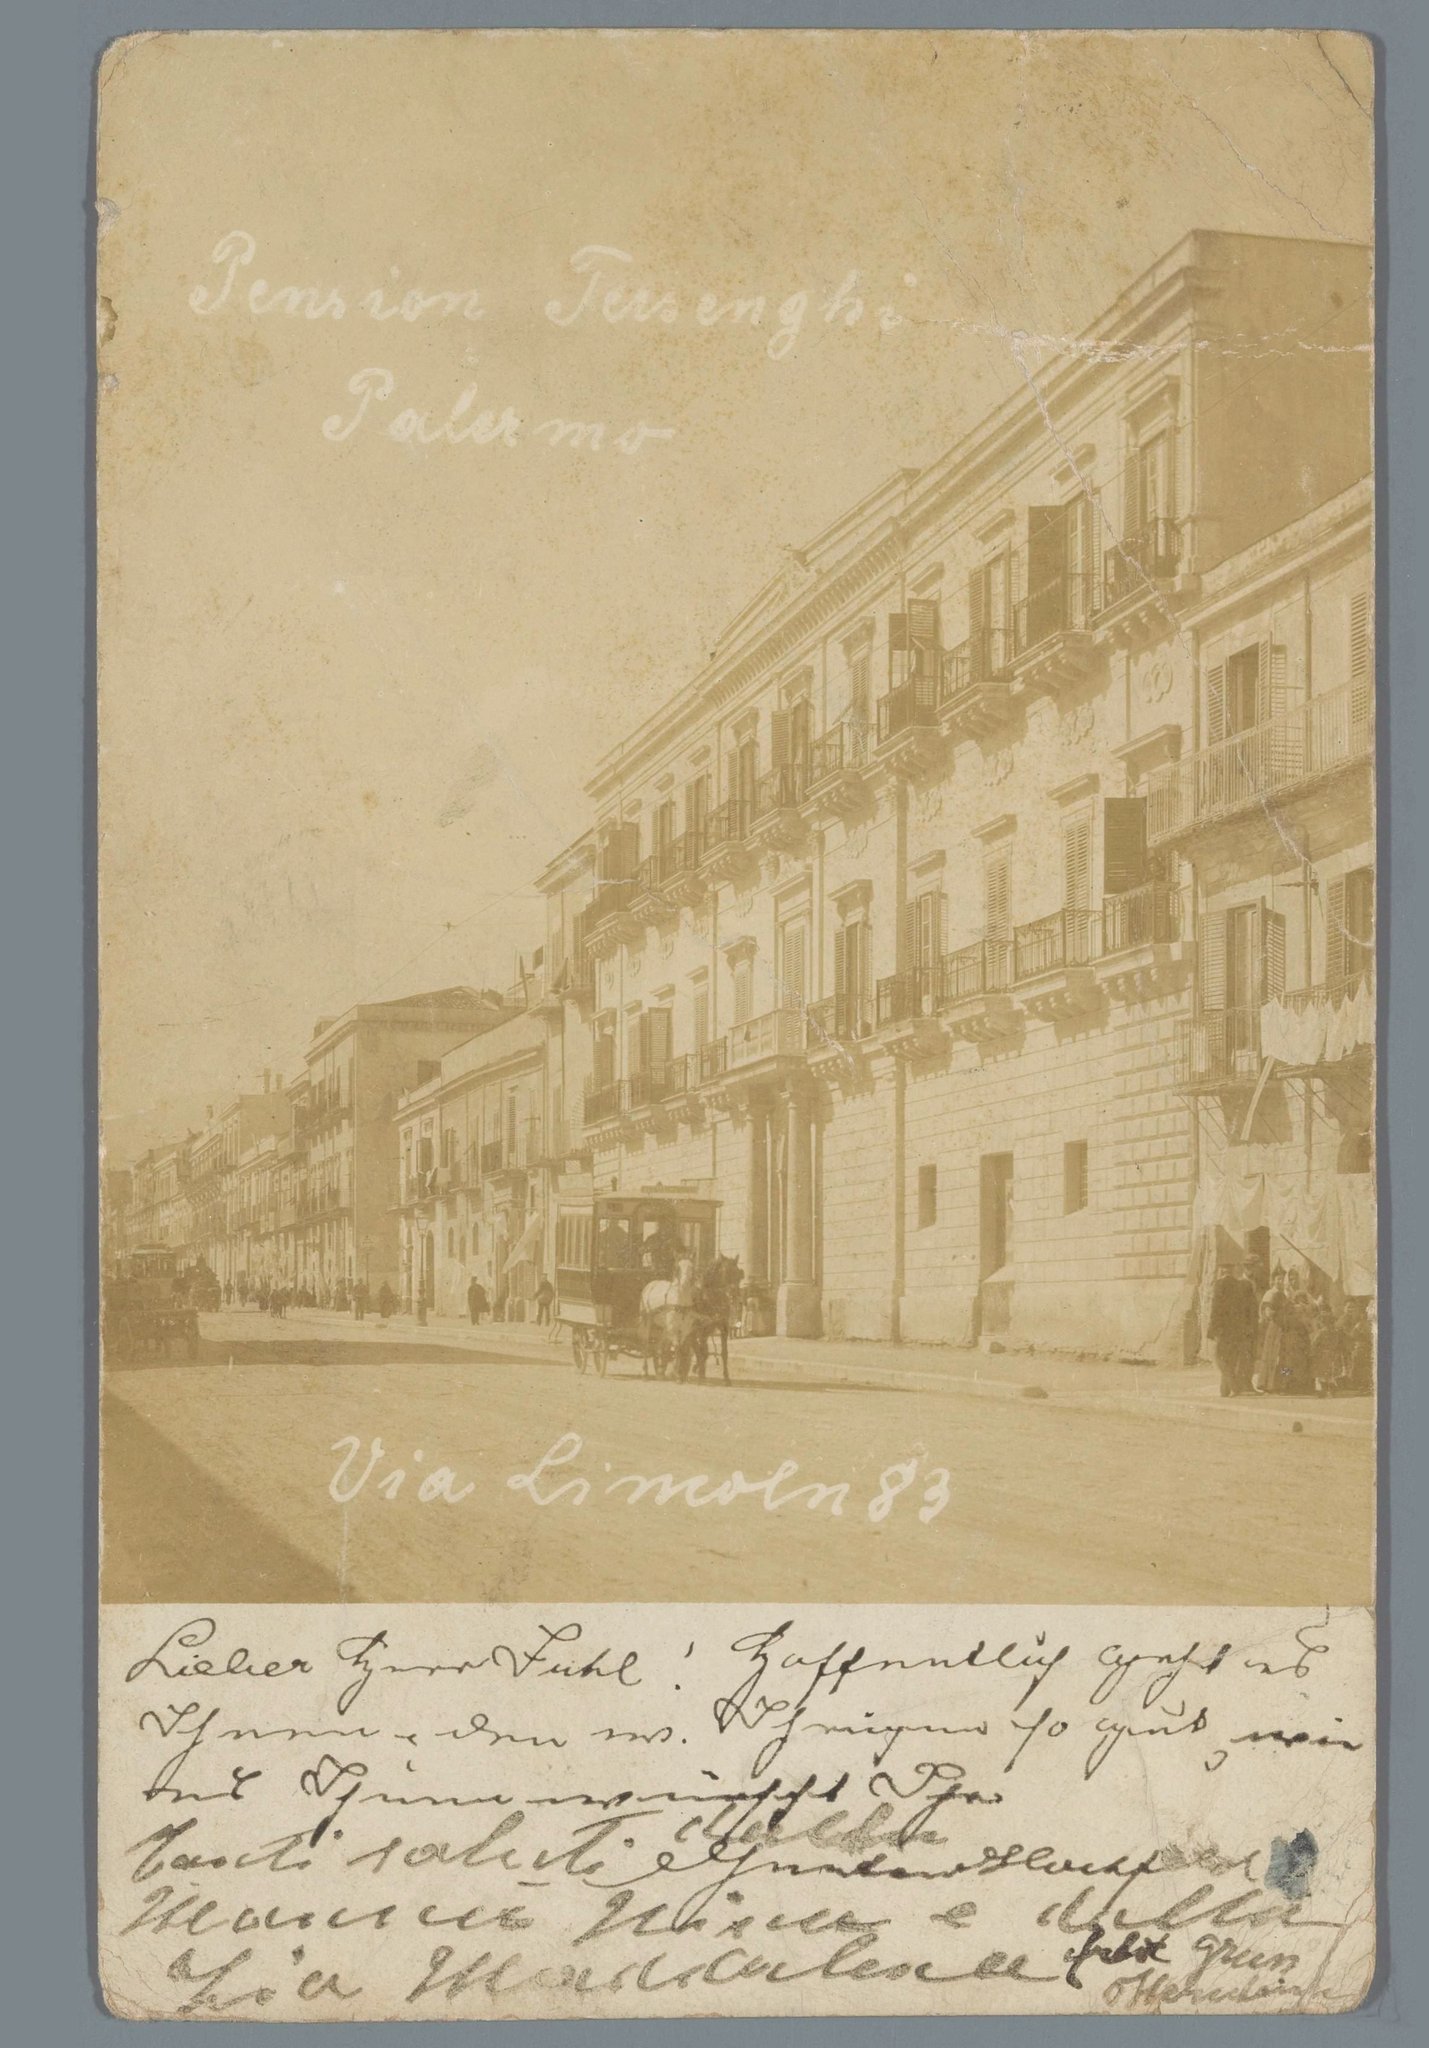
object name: photograph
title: Pension Tersenghi/ Palermo/ Via Lincoln 83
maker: Anonymous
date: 1901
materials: photographic support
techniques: writing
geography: palermo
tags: street, hotel, hostelry, inn